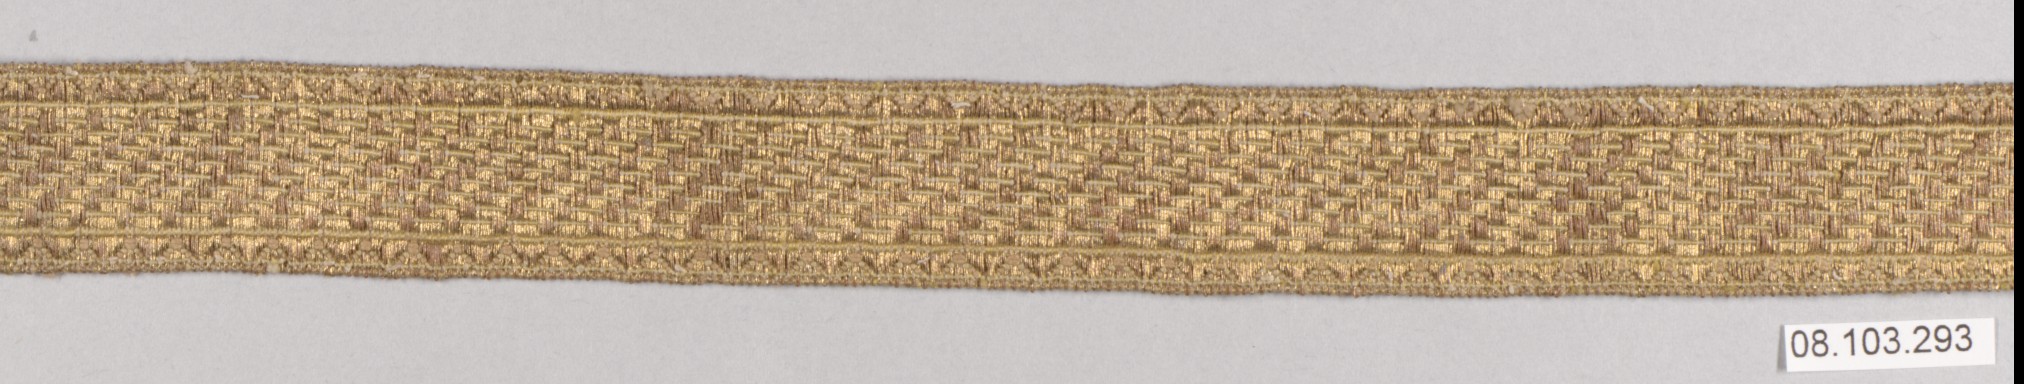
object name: galloon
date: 1601-1800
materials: metal thread